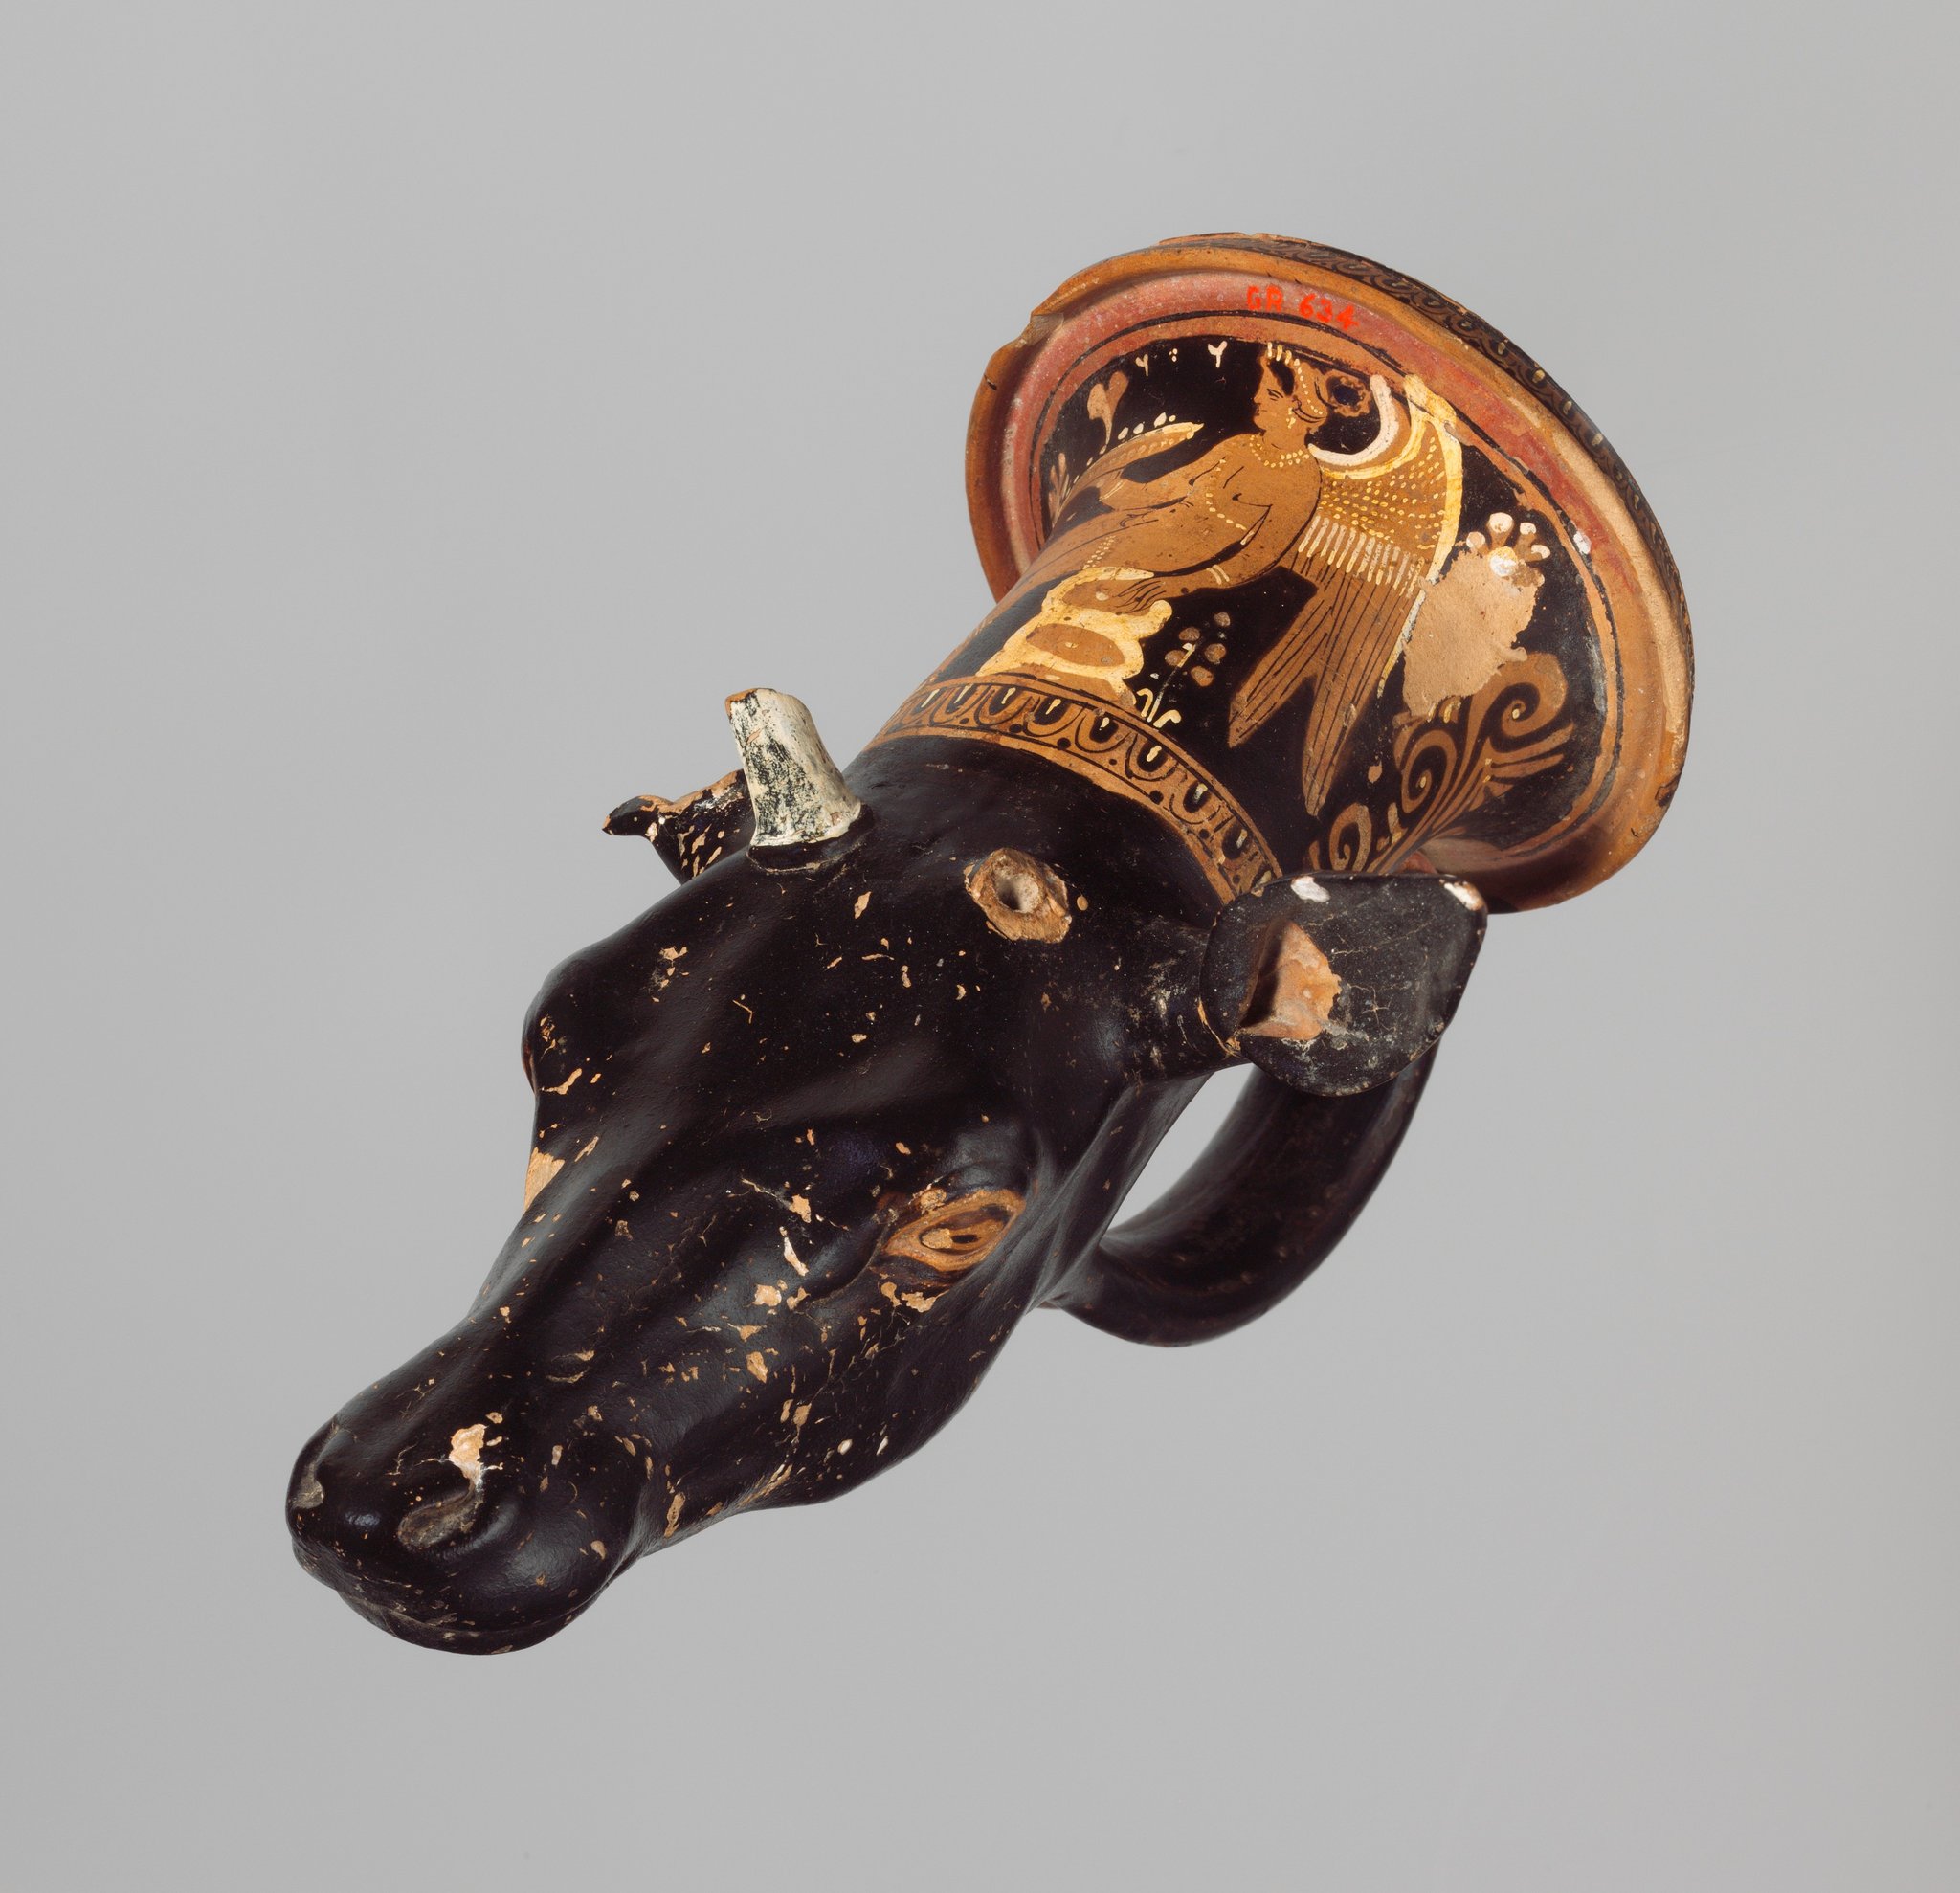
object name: rhyton in the form of a deer's head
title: Terracotta rhyton (vase for libations or drinking)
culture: greek, south italian, apulian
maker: patera-ganymede workshop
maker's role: artist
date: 350-300 BCE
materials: terracotta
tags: eros,deer